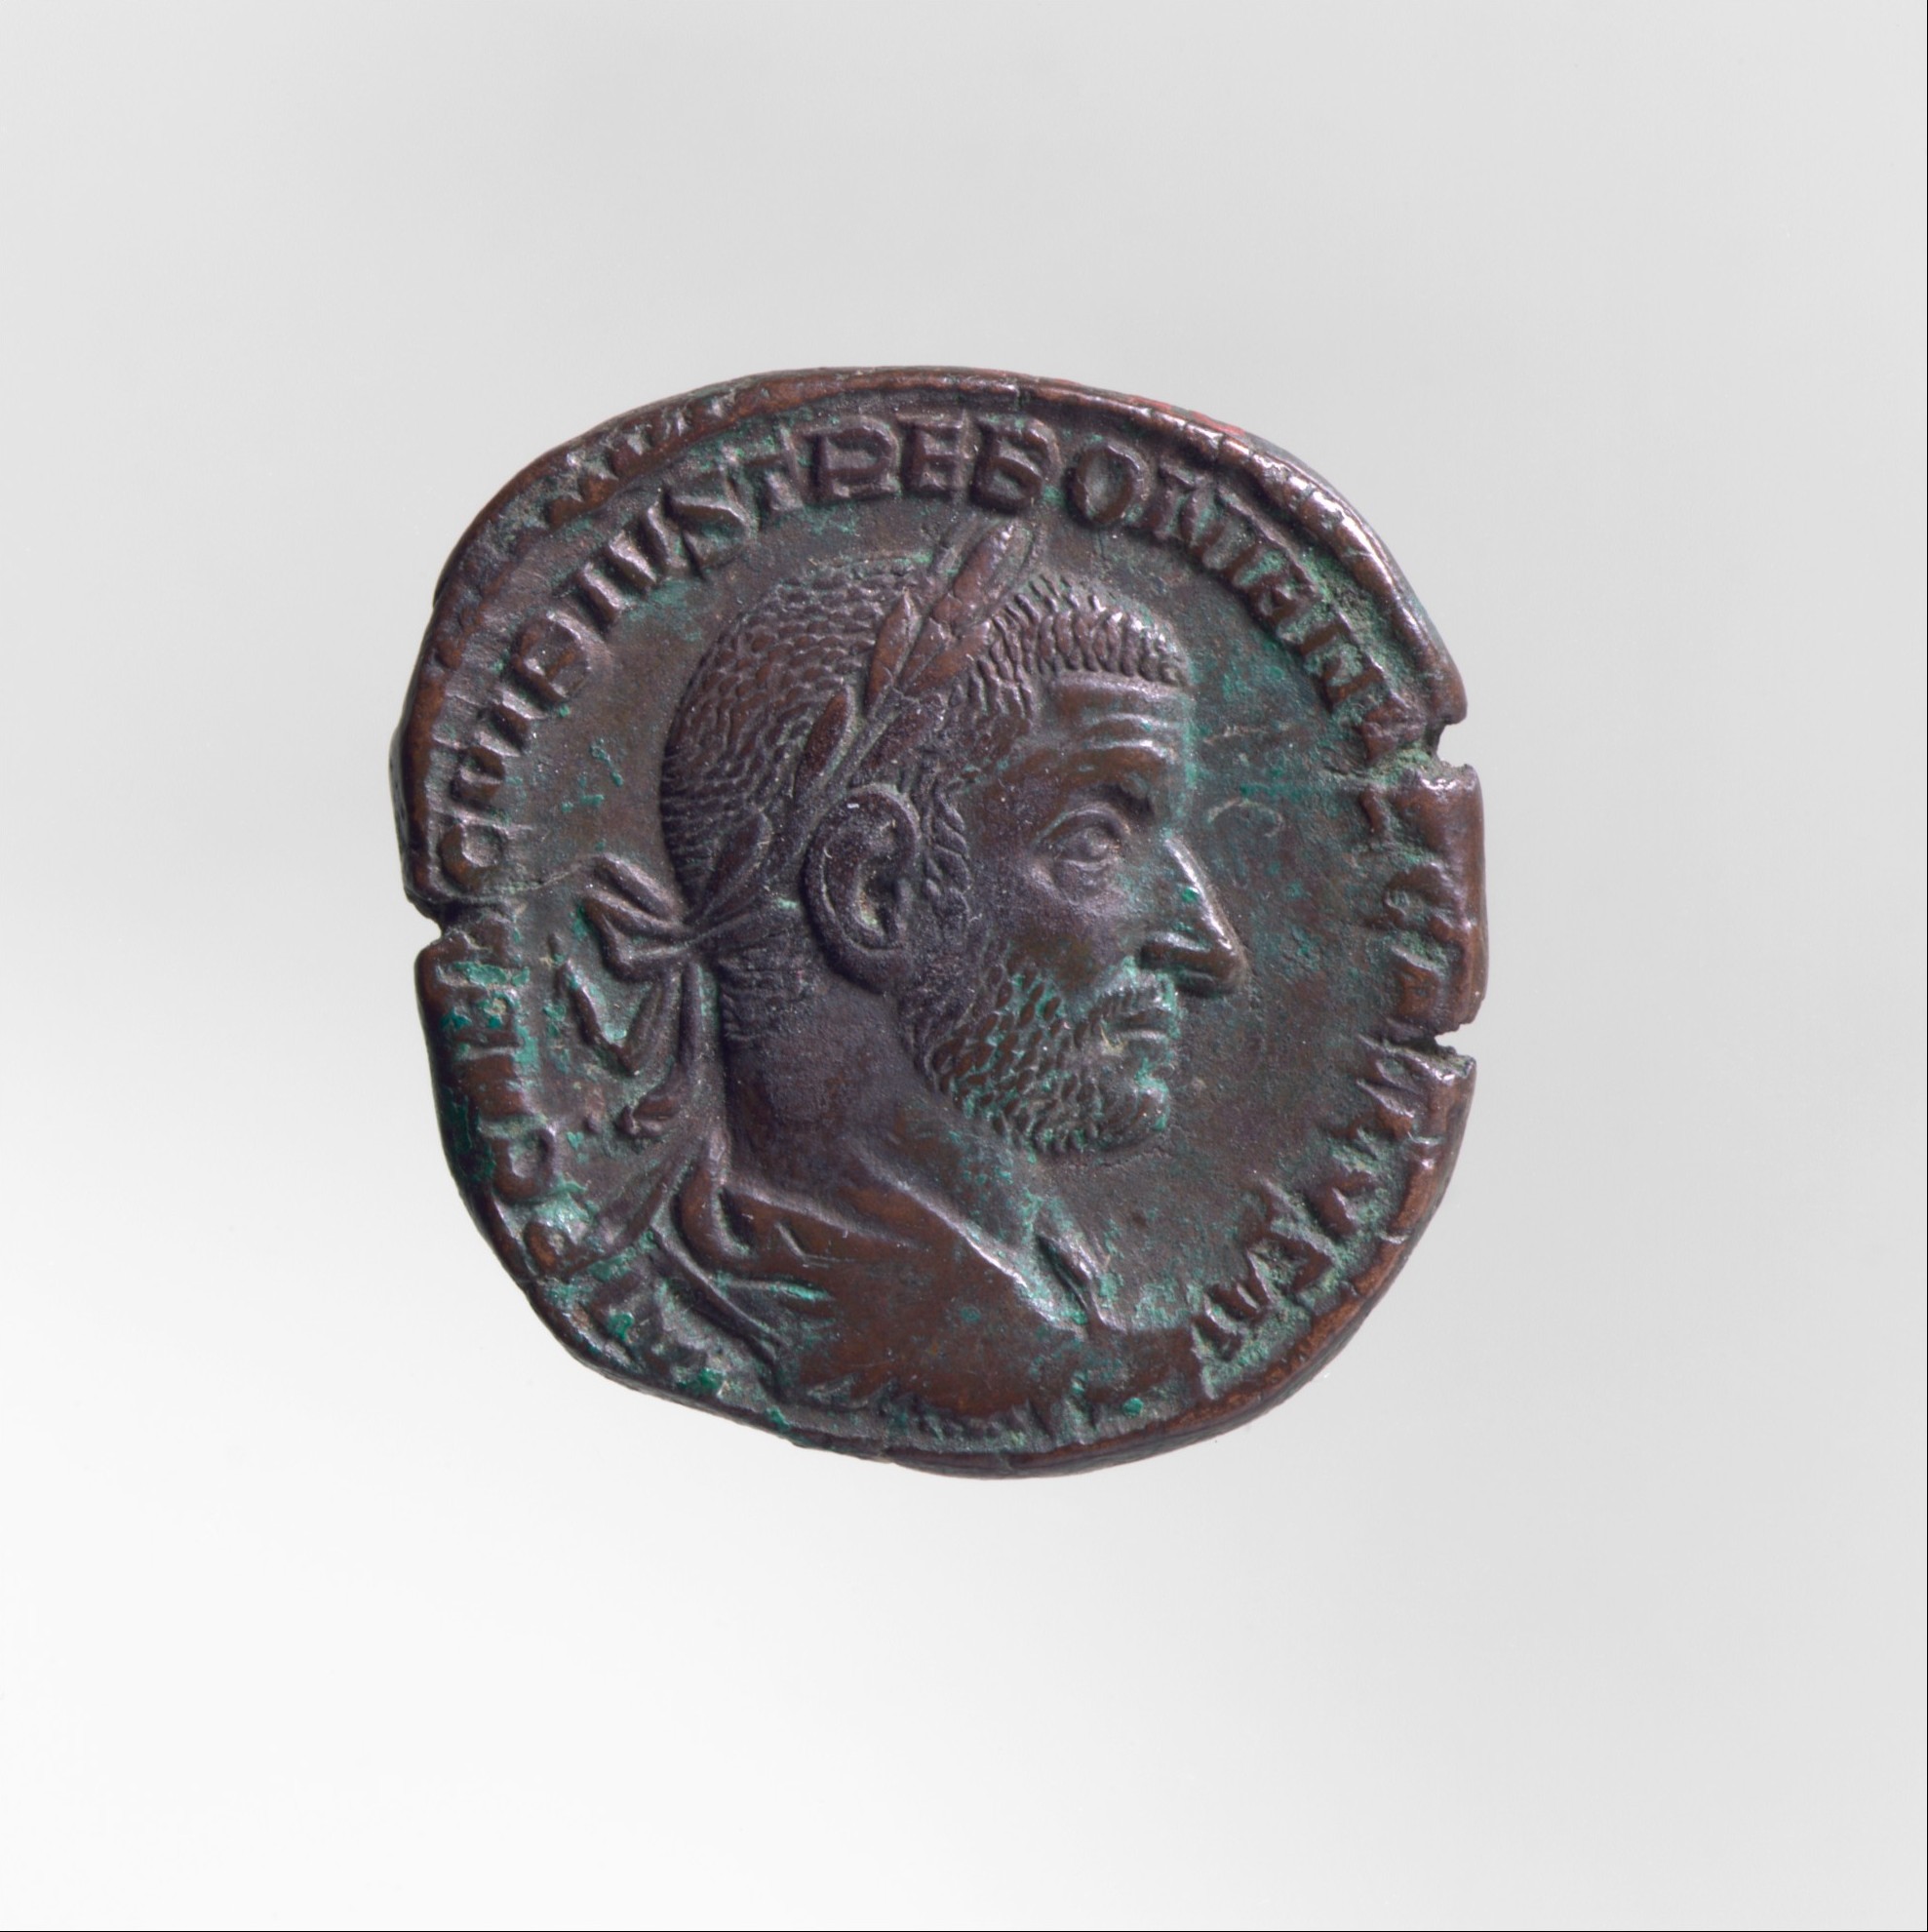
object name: sestertius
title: Bronze sestertius of Trebonianus Gallus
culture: roman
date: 251-253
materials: bronze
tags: men,profiles